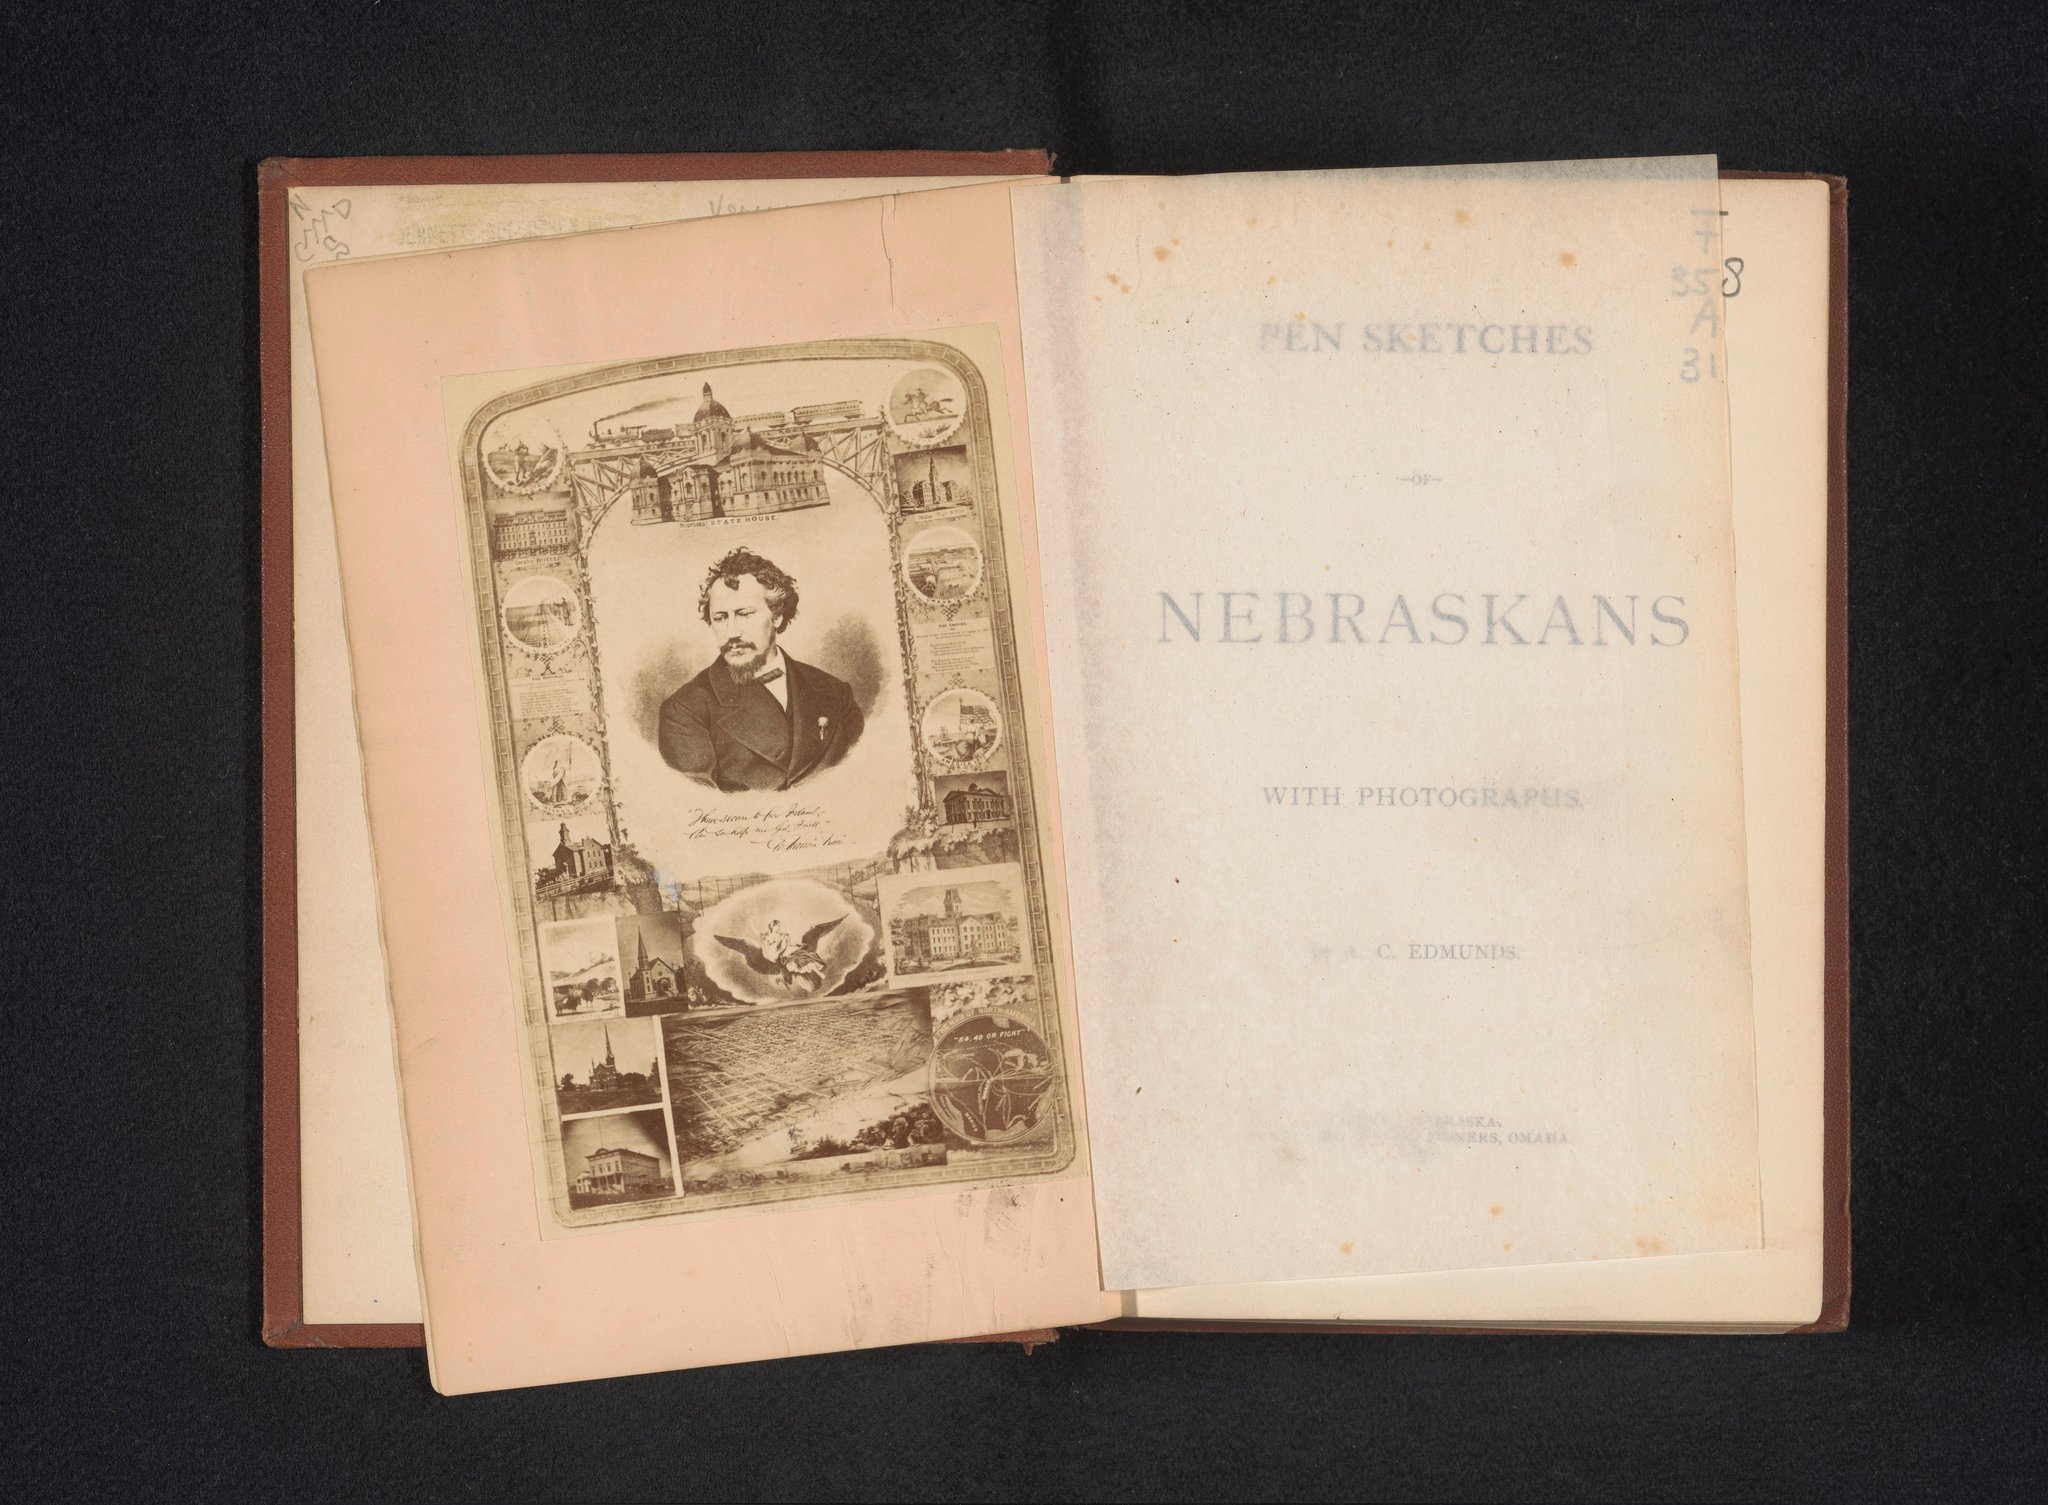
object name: page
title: Fotoreproductie van een fotomontage van Nebraska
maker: edric l. eaton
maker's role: fotograaf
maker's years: 1835-1890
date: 1866-1871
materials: photographic support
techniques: albumen print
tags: historical persons, façade (of house or building)